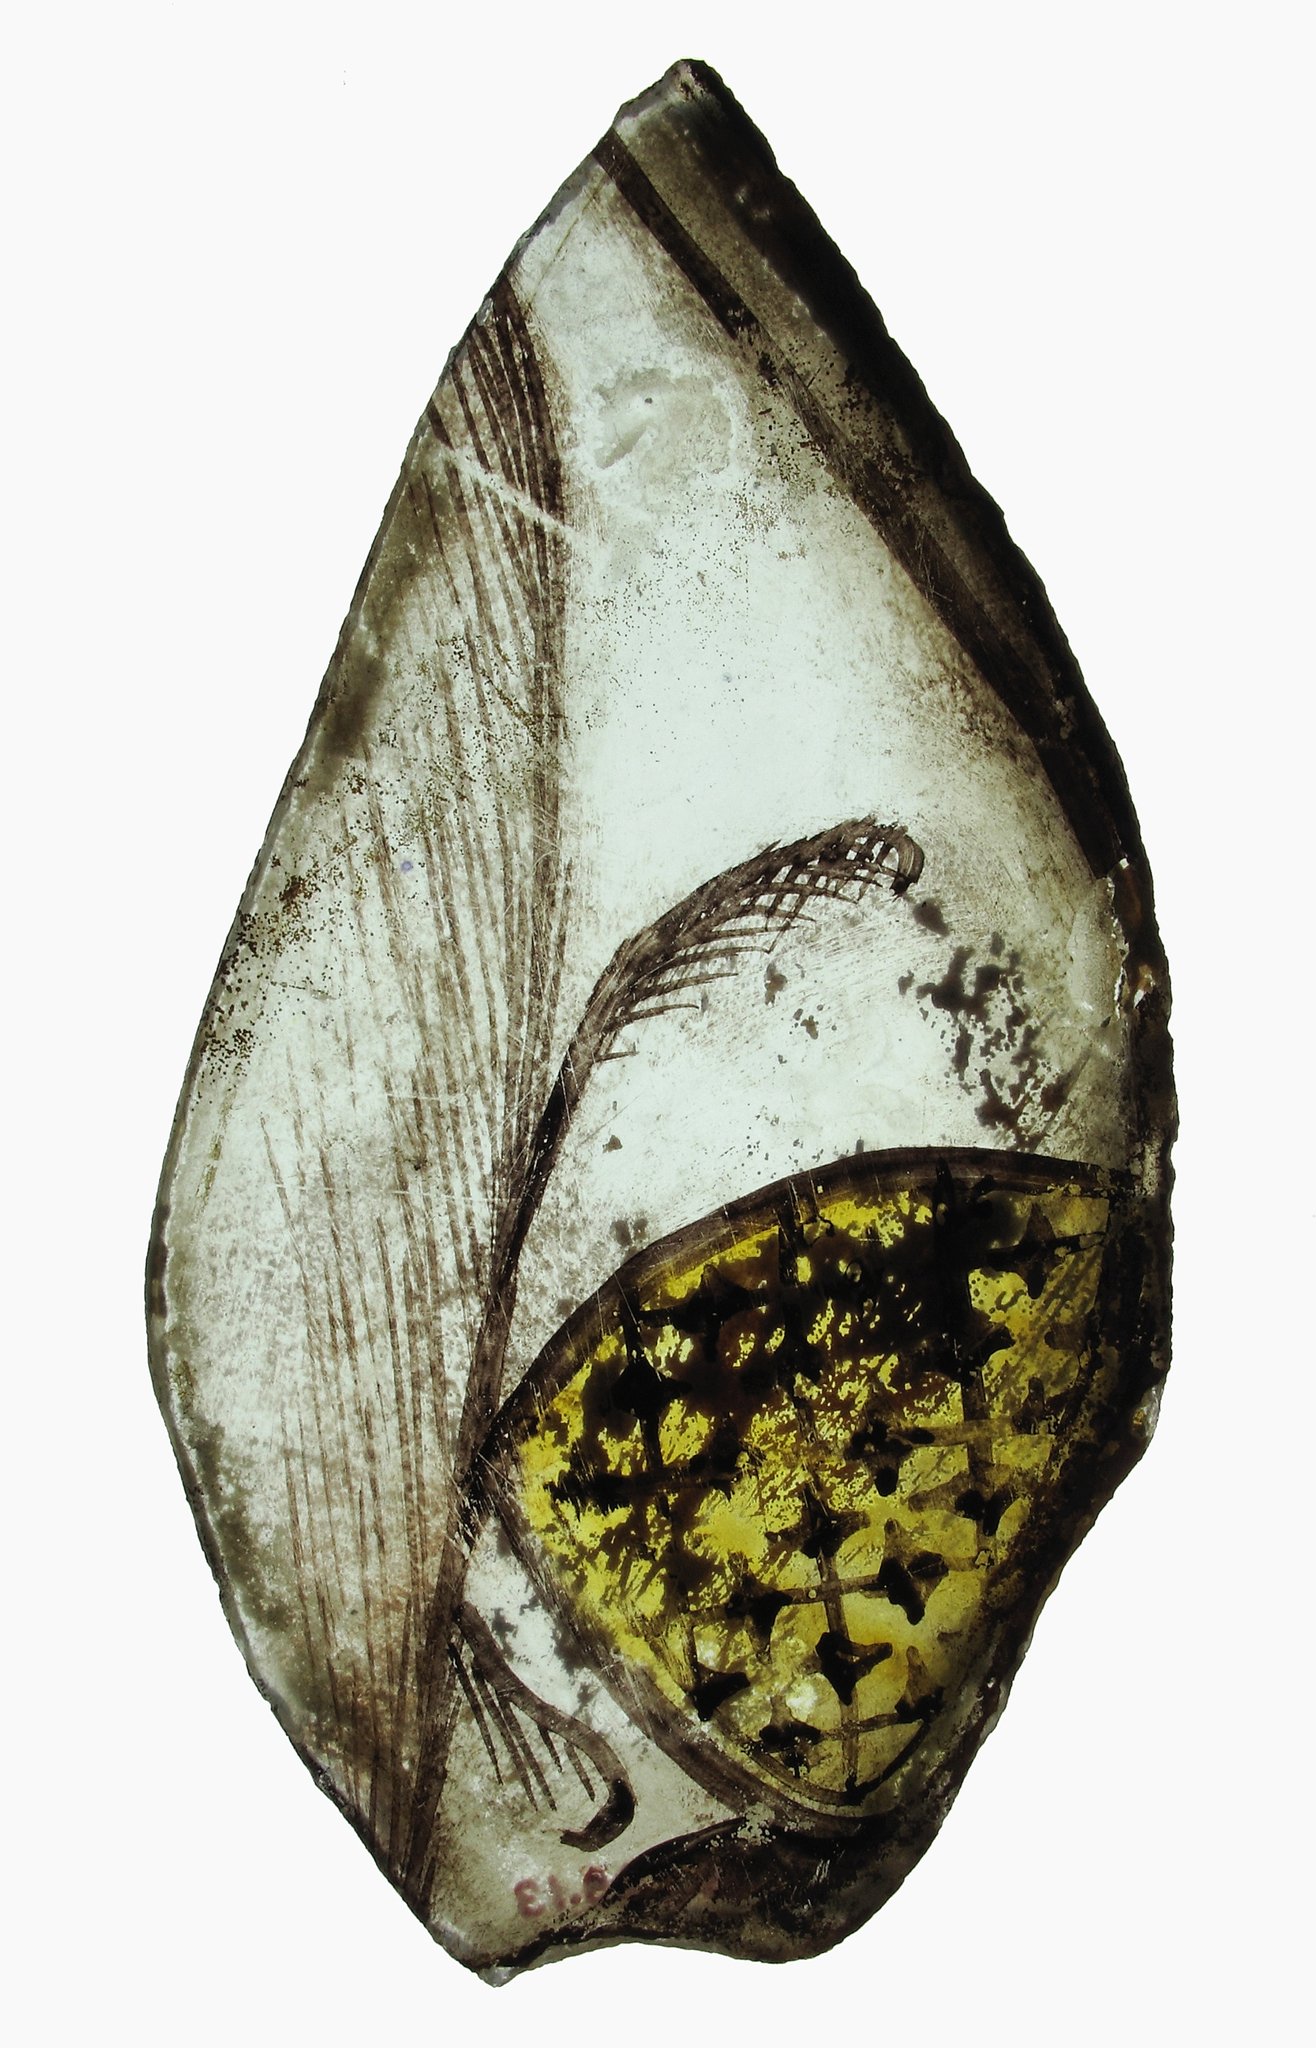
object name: fragment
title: Glass Fragment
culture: french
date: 1501-1600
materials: glass